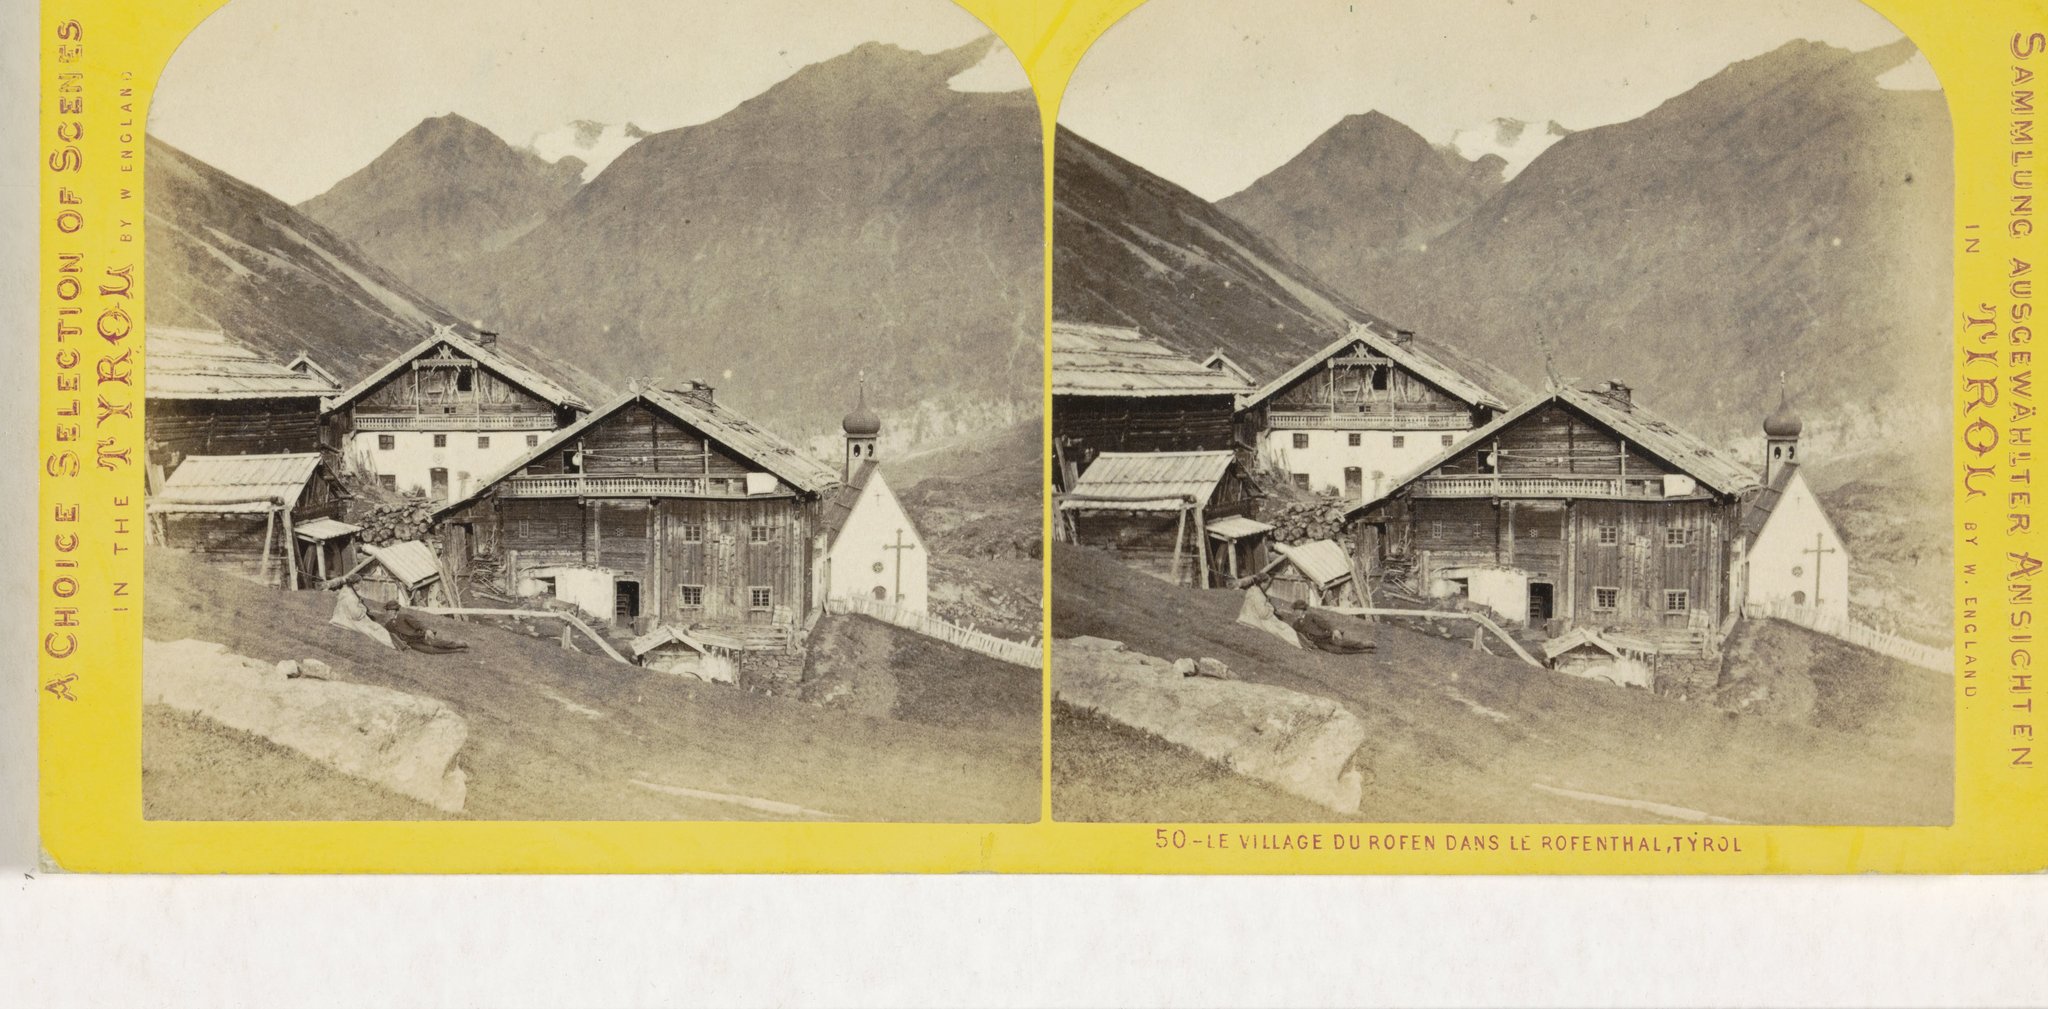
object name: stereograph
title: A Choice Selection of Scenes in the Tyrol / Sammlung ausgewählter Ansichten in Tirol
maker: william england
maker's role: fotograaf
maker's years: 1816-1896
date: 1863-1865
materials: cardboard, paper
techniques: albumen print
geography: rofen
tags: village, mountains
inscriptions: number: ‘50’